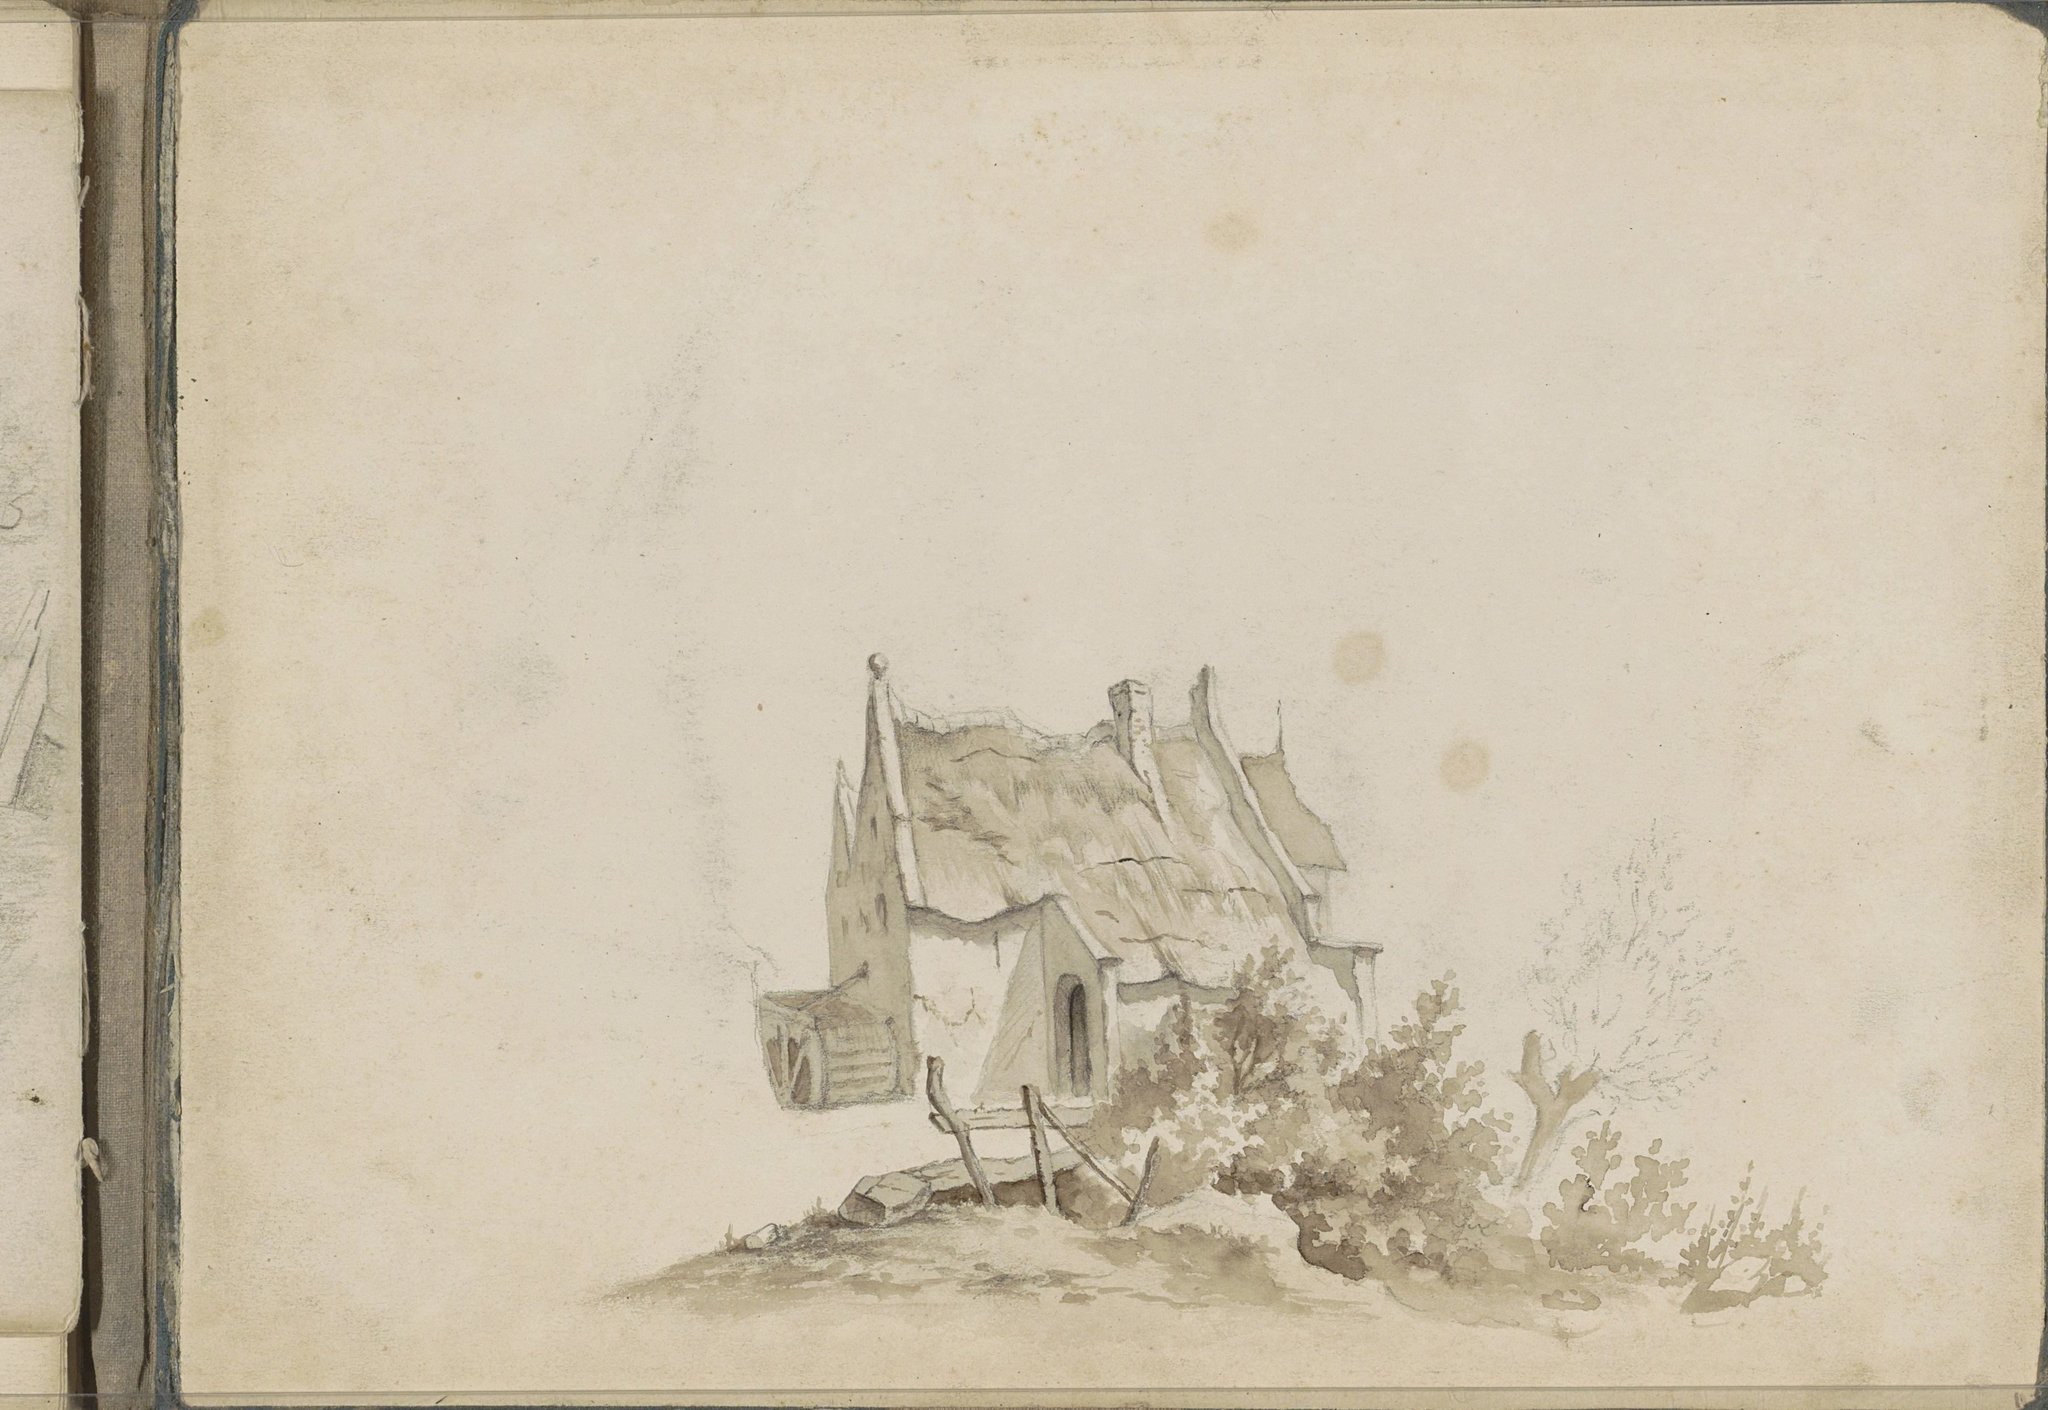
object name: sketchbook leaf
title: Huis met een watermolen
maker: willem cornelis rip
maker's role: draughtsman, painter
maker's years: 1856-1922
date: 1874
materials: ink, paper, pencil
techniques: brush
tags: watermill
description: Achterste schutblad uit een schetsboek met 27 losse bladen.